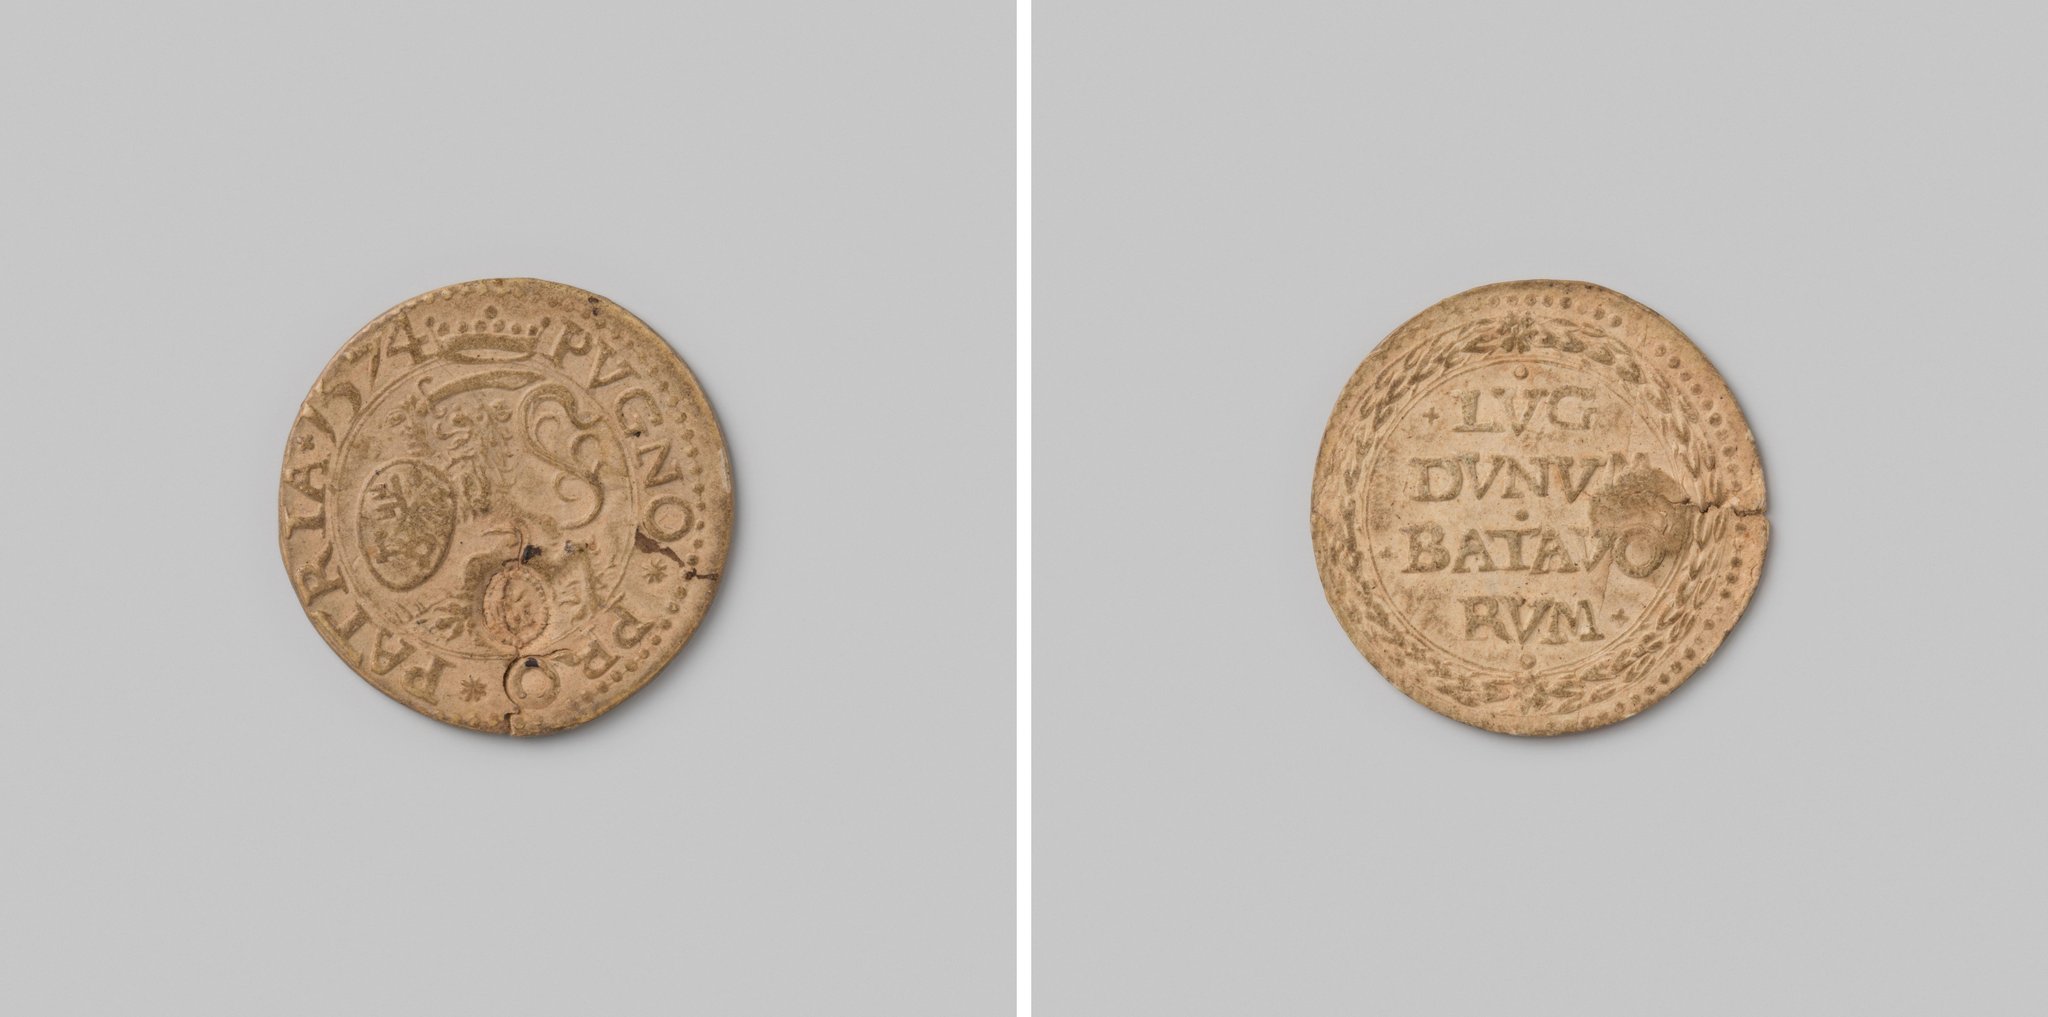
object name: coin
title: Kwart gulden, noodmunt uit Leiden, geslagen tijdens het beleg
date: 1501-1574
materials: paper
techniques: printing, pressing, striking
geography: leiden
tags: leiden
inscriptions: circumscription: ‘PUGNO PRO PATRIA 1574’, inscription: ‘LUGDUNUM BATAVORUM’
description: Noodmunt uit Leiden: kwart gulden. Gemaakt van samengeperste bladen van misboeken. Kwart gulden. Voorzijde: klimmende leeuw naar links, het zwaard heffend in de rechtervoorpoot en een schild waarop twee sleutels (wapen van de stad Leiden) in de linkervoorpoot. Boven een kroon en onder een ingestansd merk (leeuw) met omschrift. Keerzijde: binnen lauwerkrans opschrift in vier regels.